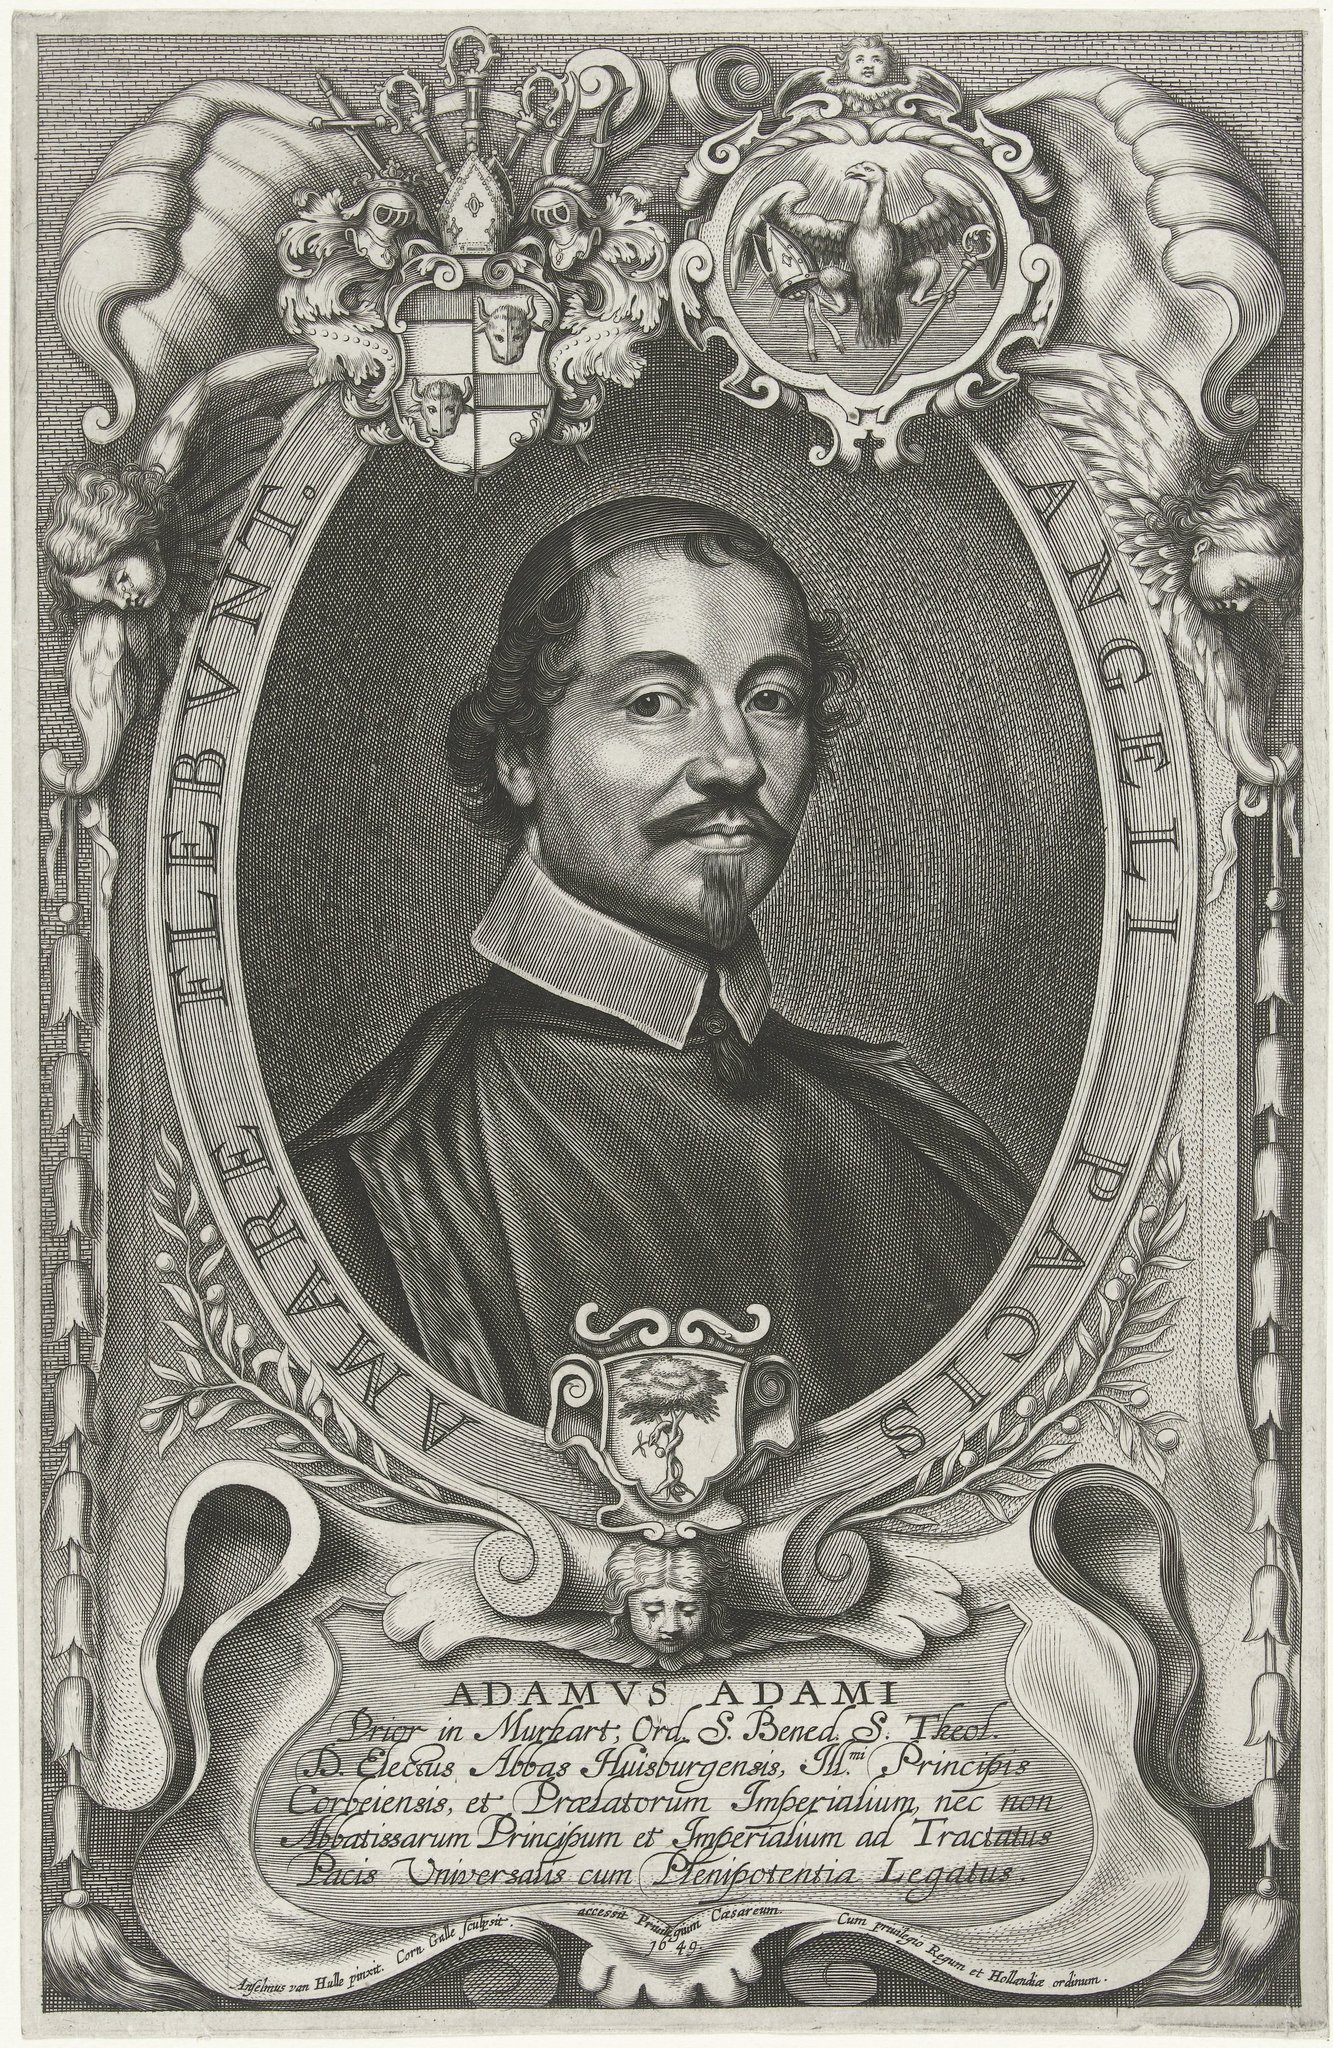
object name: print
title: Celeberrimi ad pacificandum Christiani nominis orbem legati Monasterium et Osnabrugas (...)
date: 1649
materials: paper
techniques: engraving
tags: hildesheim, bisschop, abt, afgezant, adam adami, vrede van münster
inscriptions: collector's mark: Lugt 2228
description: Portret van Adam Adami, afgevaardigde bij de onderhandelingen rond de Vrede van Münster, in ovaal met sierlijst. In de lijst zijn drie wapens verwerkt.